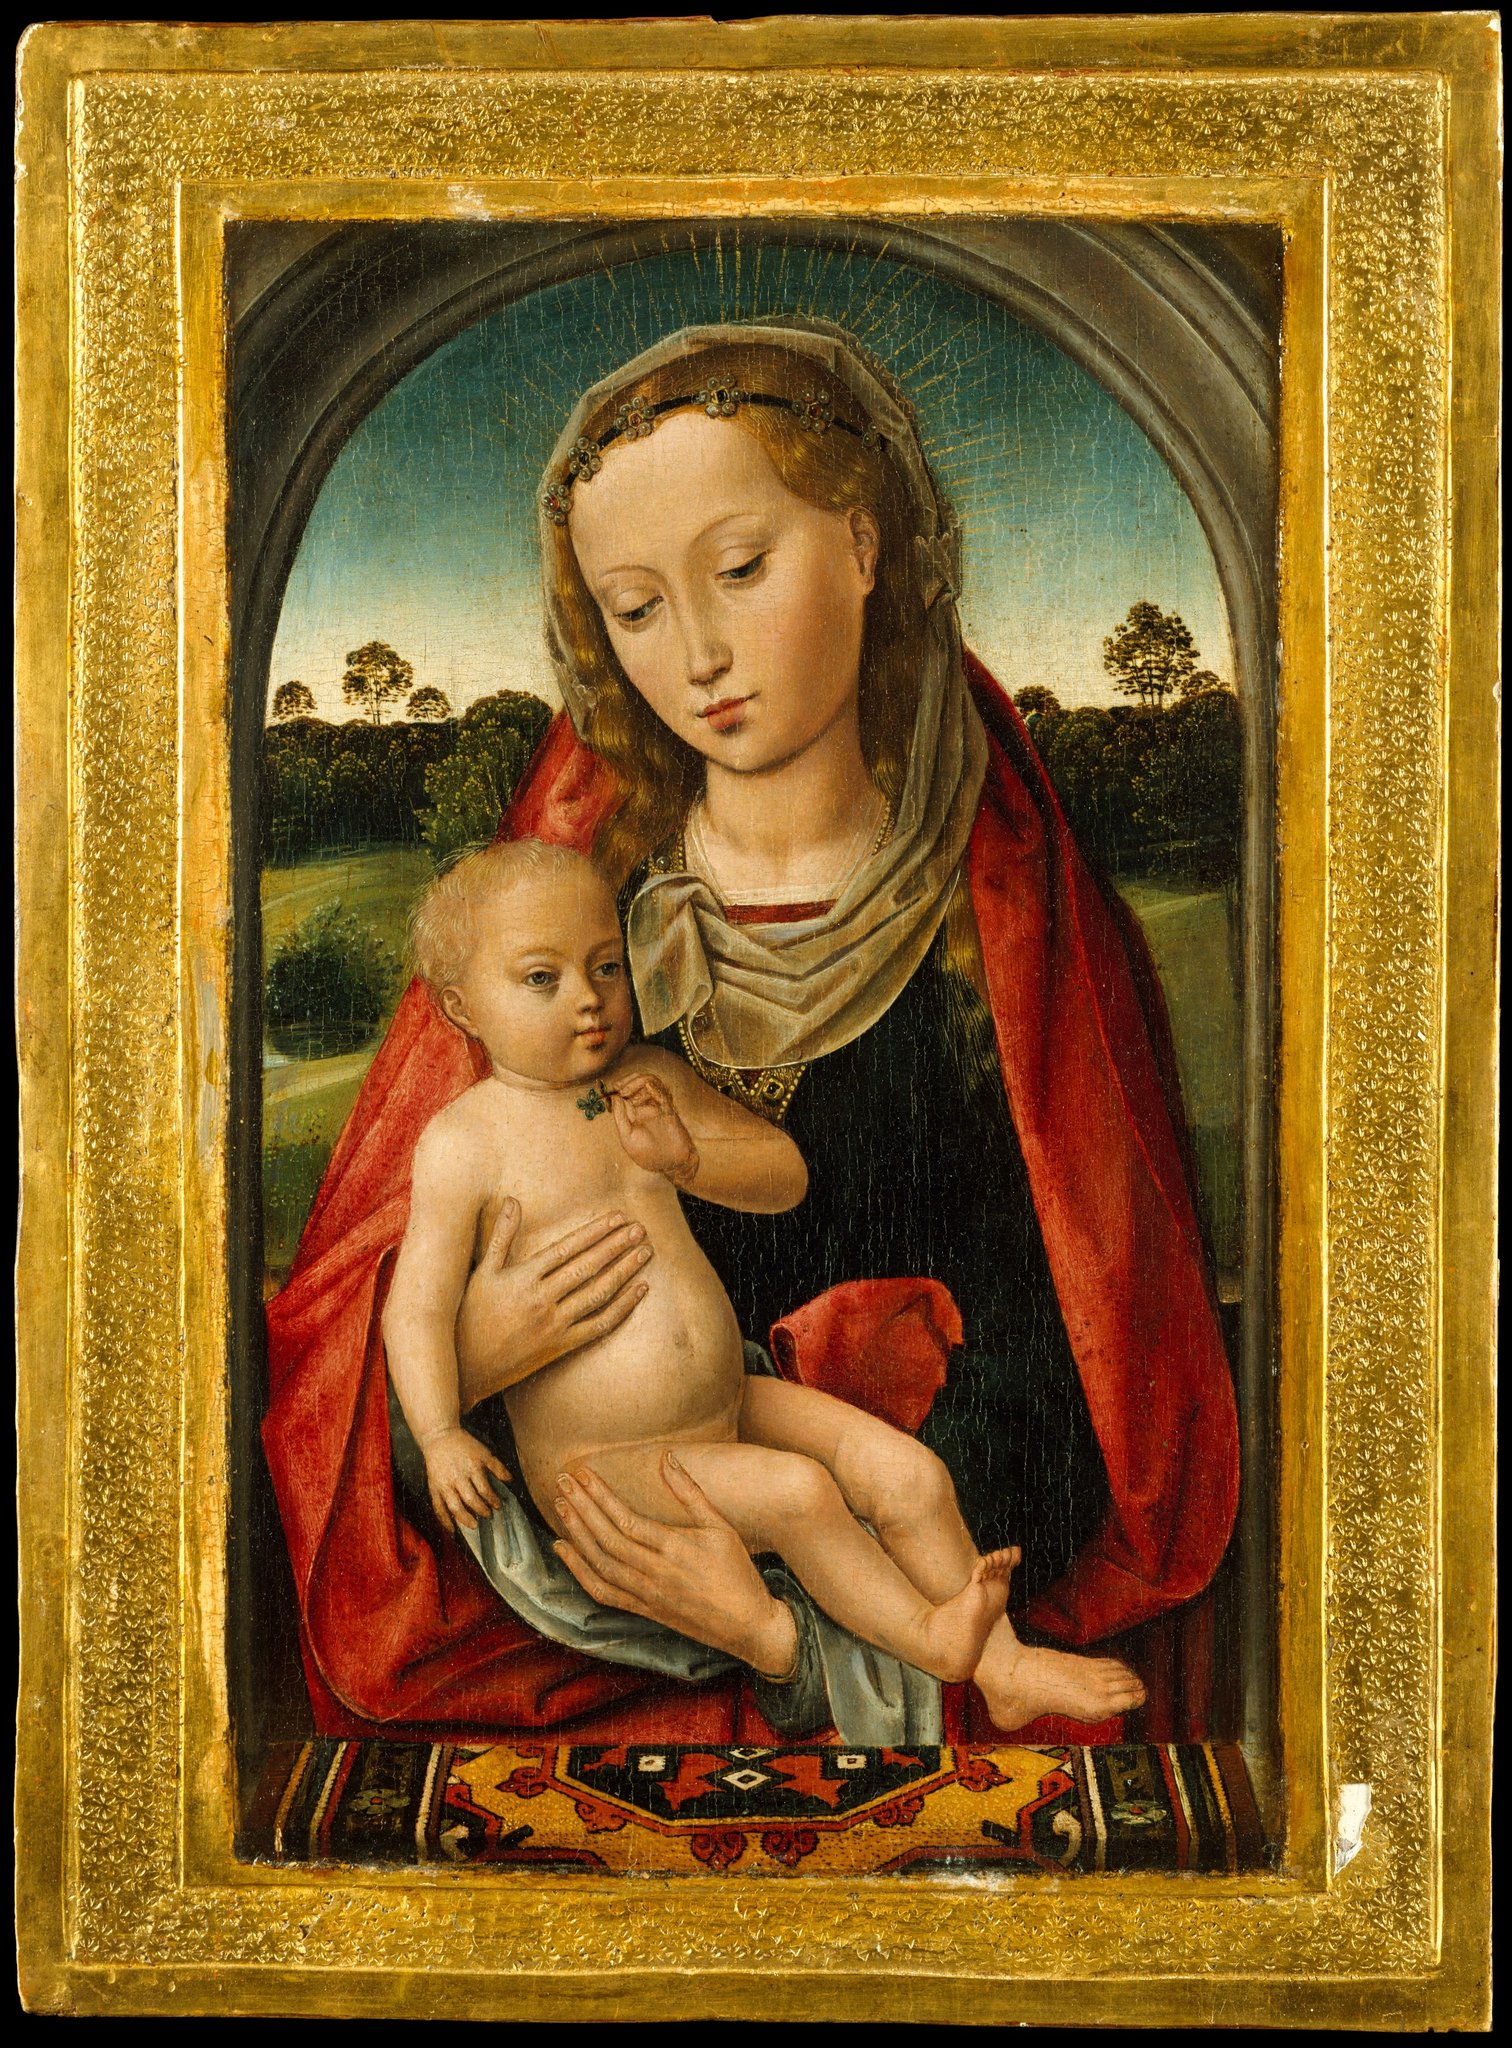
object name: painting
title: Virgin and Child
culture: dutch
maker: hans memling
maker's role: artist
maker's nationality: netherlandish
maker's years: 1465-1494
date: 1501-1533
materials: wood, oil, panel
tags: madonna and child